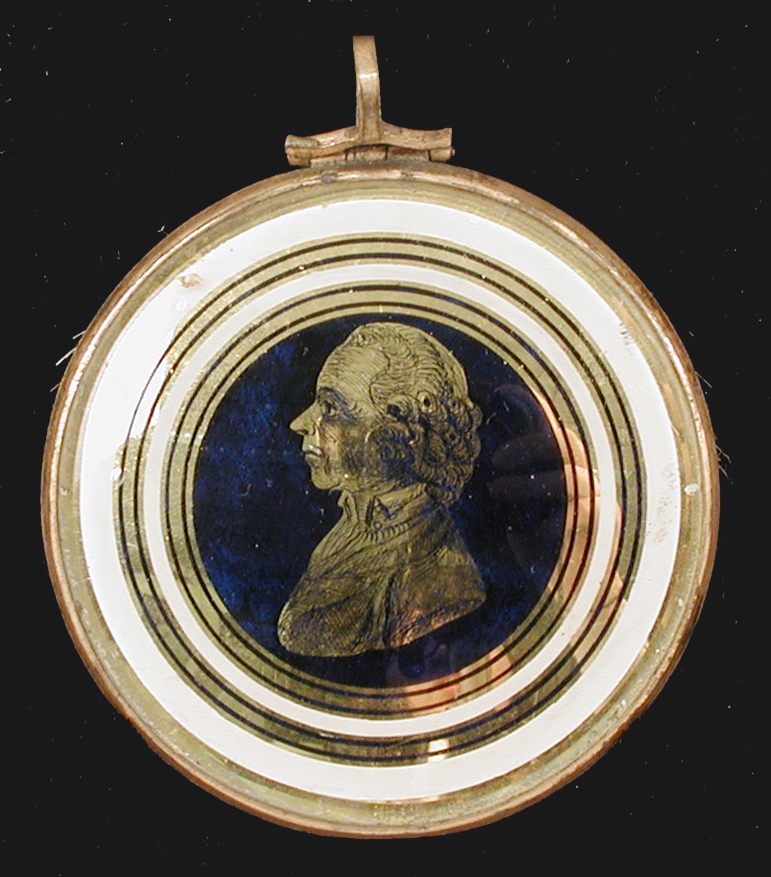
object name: locket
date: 1801-1900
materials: glass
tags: men,profiles